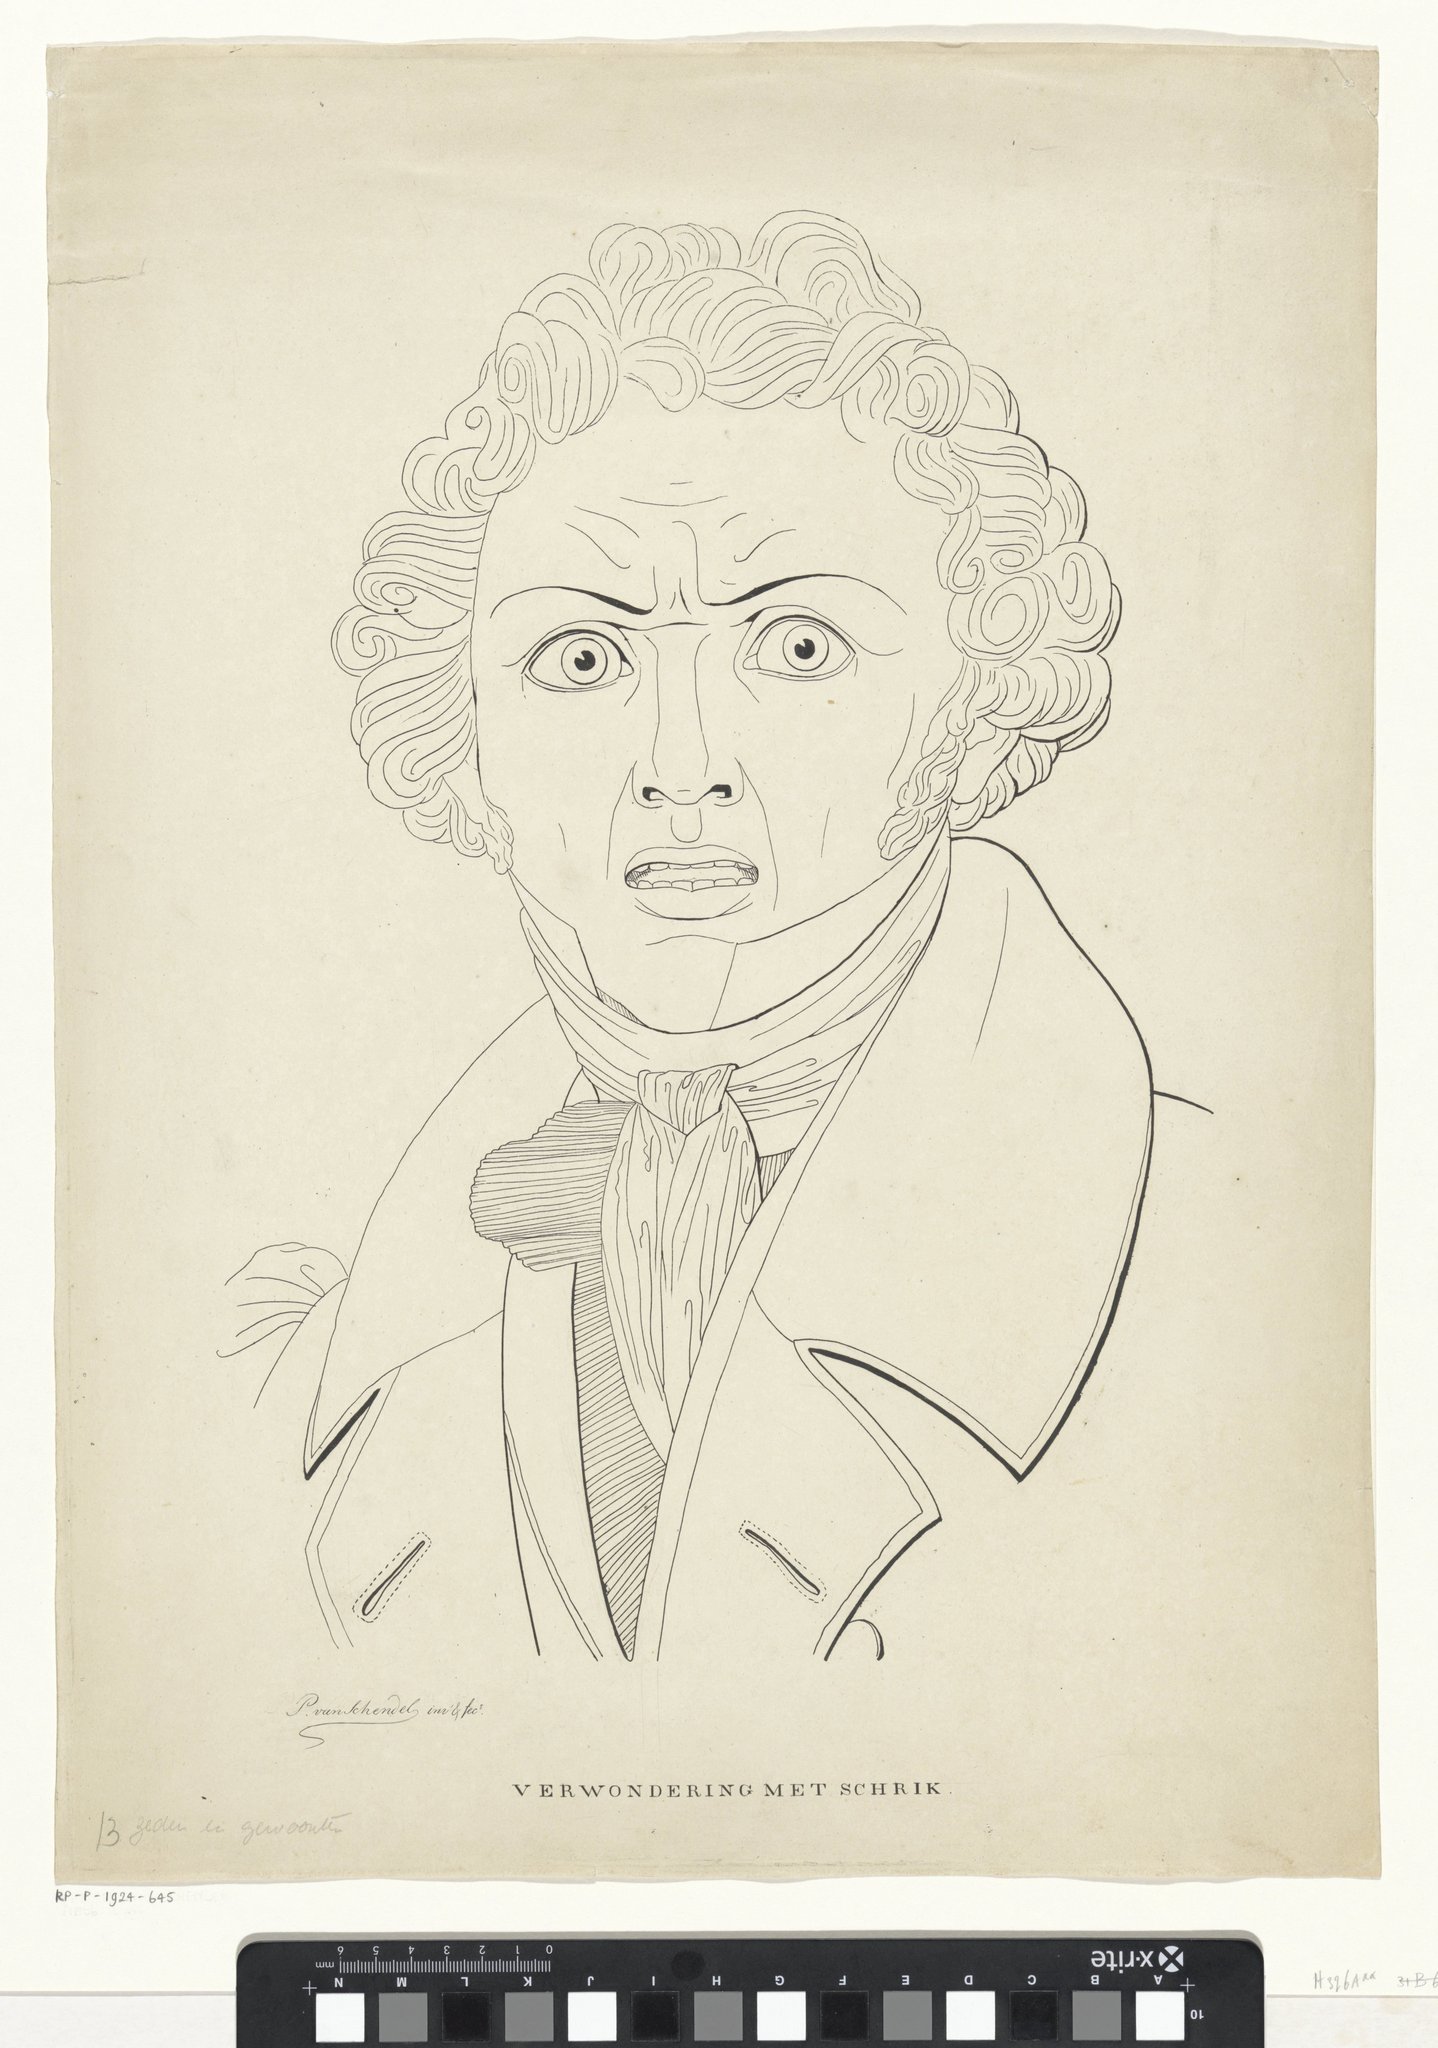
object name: print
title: De Hartstogten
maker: petrus van schendel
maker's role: draughtsman, painter, print maker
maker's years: 1806-1870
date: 1834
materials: paper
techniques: etching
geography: rotterdam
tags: passions, emotions, affections, frowned eyebrows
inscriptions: collector's mark: Lugt 2233, collector's mark: Lugt 2228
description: Prent was een proefdruk om potentiële afnemers te interesseren voor het werk: Schendel, Petrus van. De hartstogten, afgebeeld in 72 expressiehoofden, Rotterdam: Wed. van der Meer & Verbruggen, 1834